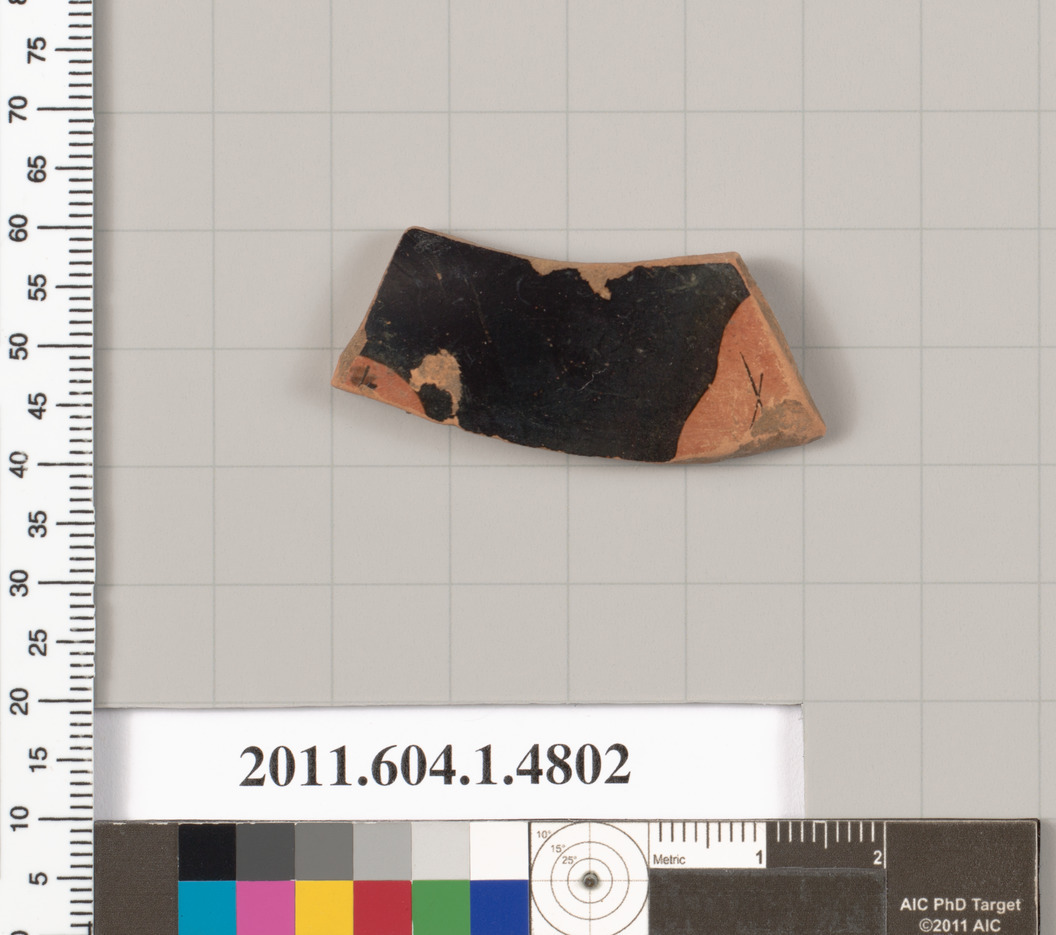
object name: kylix fragment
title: Terracotta fragment of a kylix (drinking cup)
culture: greek, attic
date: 460-450 BCE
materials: terracotta